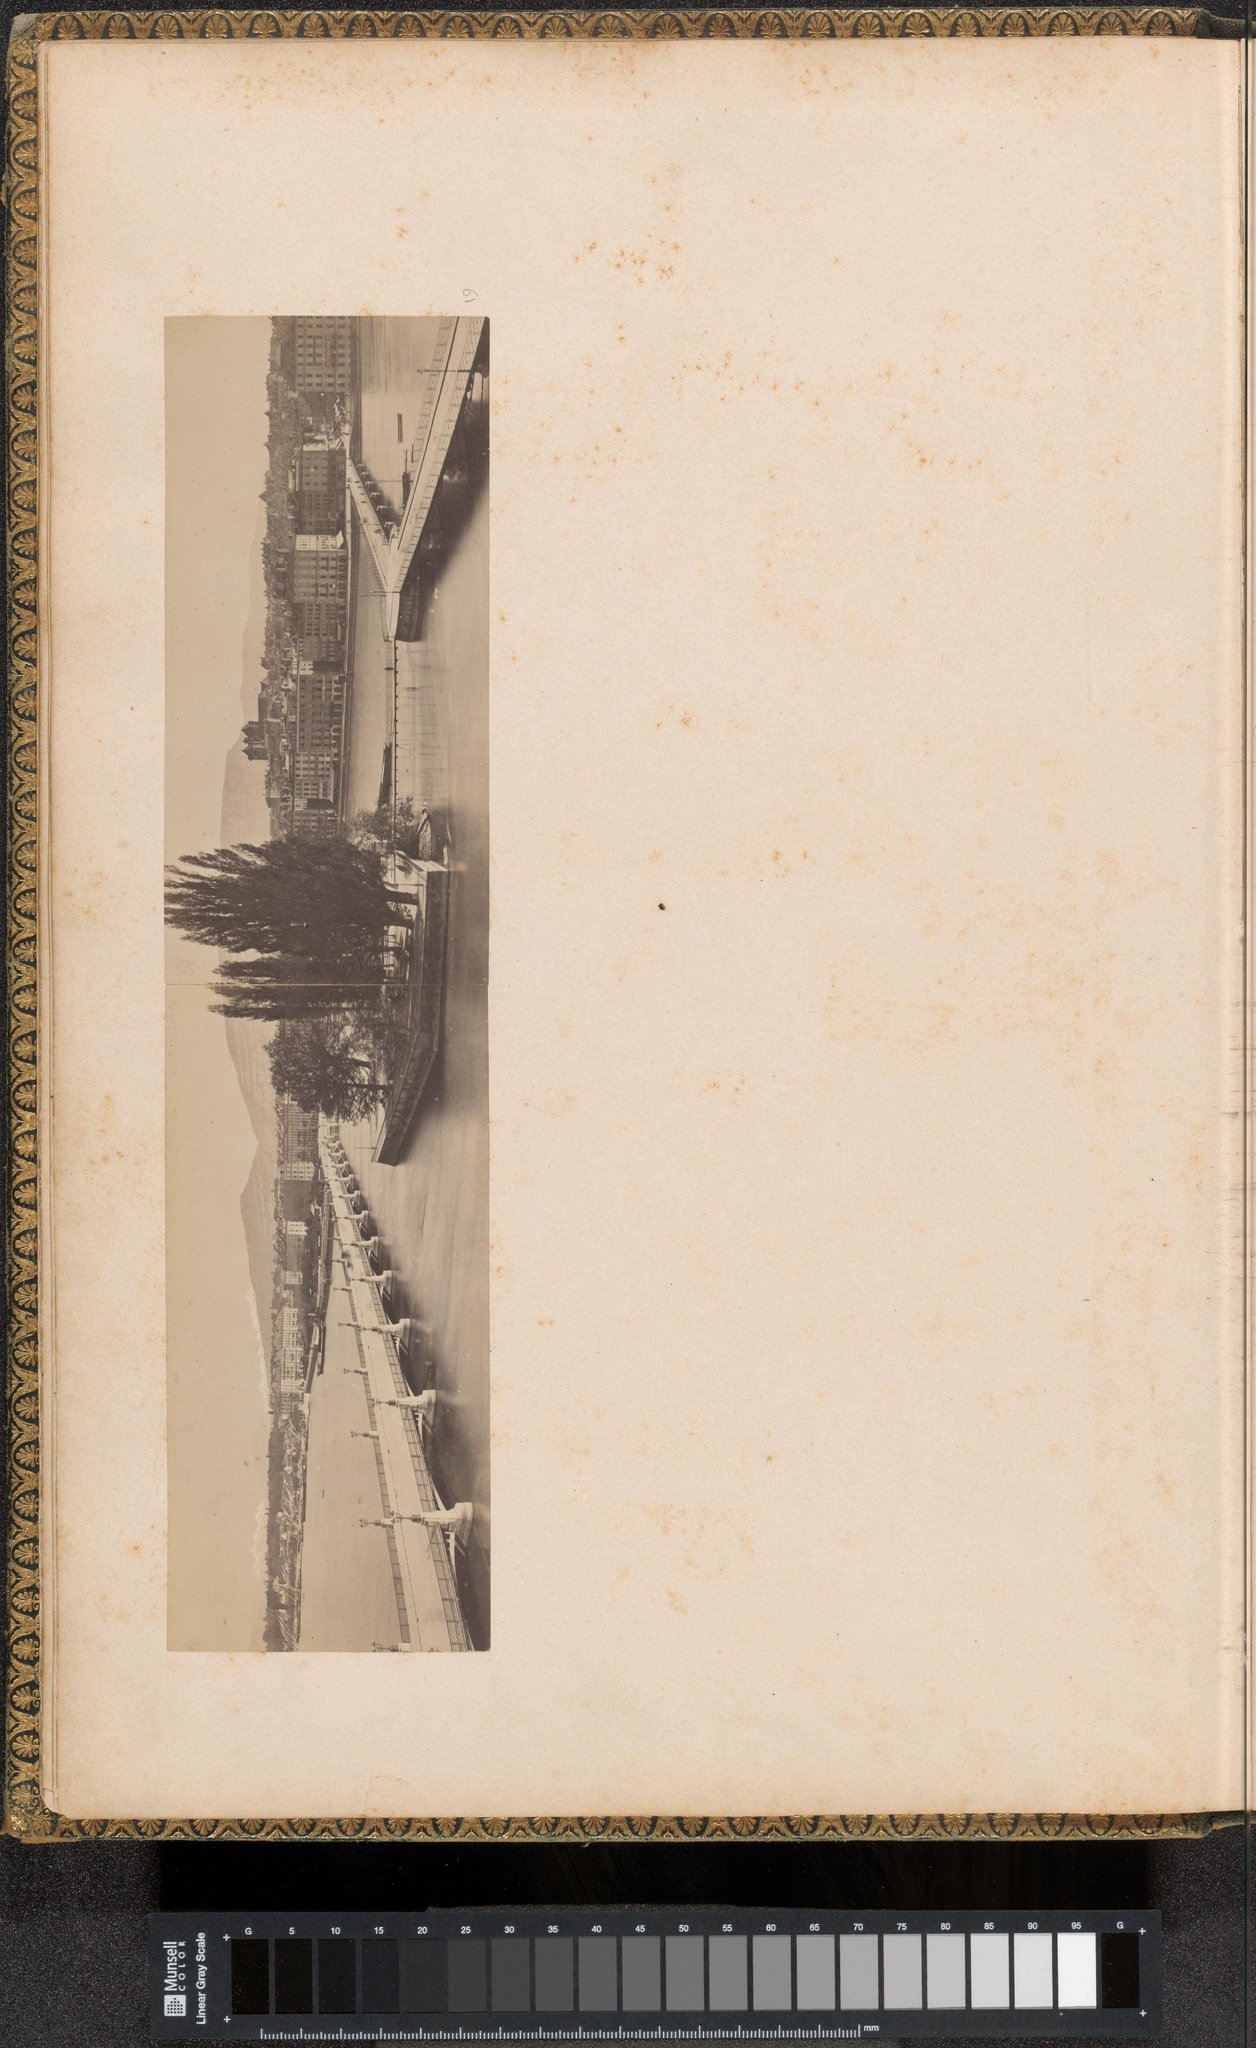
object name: album leaf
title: Panorama van Genève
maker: Anonymous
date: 1860-1865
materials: paper, photographic support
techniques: albumen print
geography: geneva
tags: bridge in city across river, canal, etc., prospect of city, town panorama, silhouette of city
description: Panorama bestaande uit twee afdrukken. Onderdeel van Fotoalbum van Robert Daniel Crommelin (1841-1907).